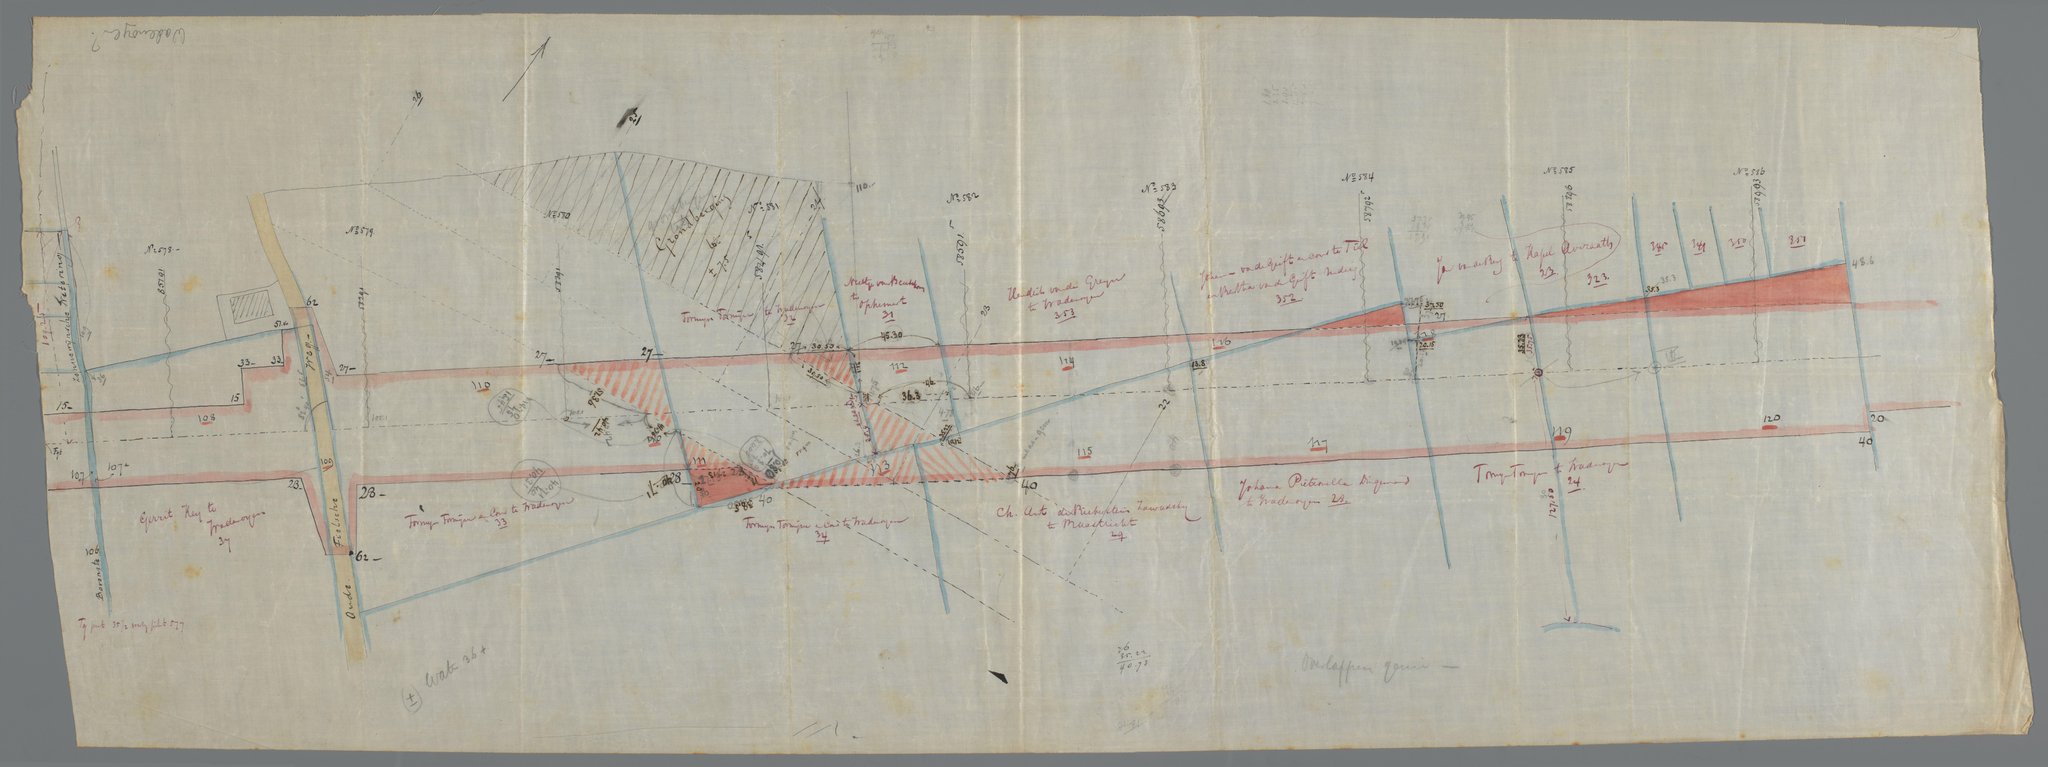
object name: drawing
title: Verkavelingsplattegrond in Tiel bij de Oude Tielseweg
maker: Anonymous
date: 1850-1900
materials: ink, linen, pencil, watercolor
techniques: brush, pen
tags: urban housing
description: Plattegrond in Tiel met schematisch de verkaveling en straten weergegeven, met namen van grondbezitters.